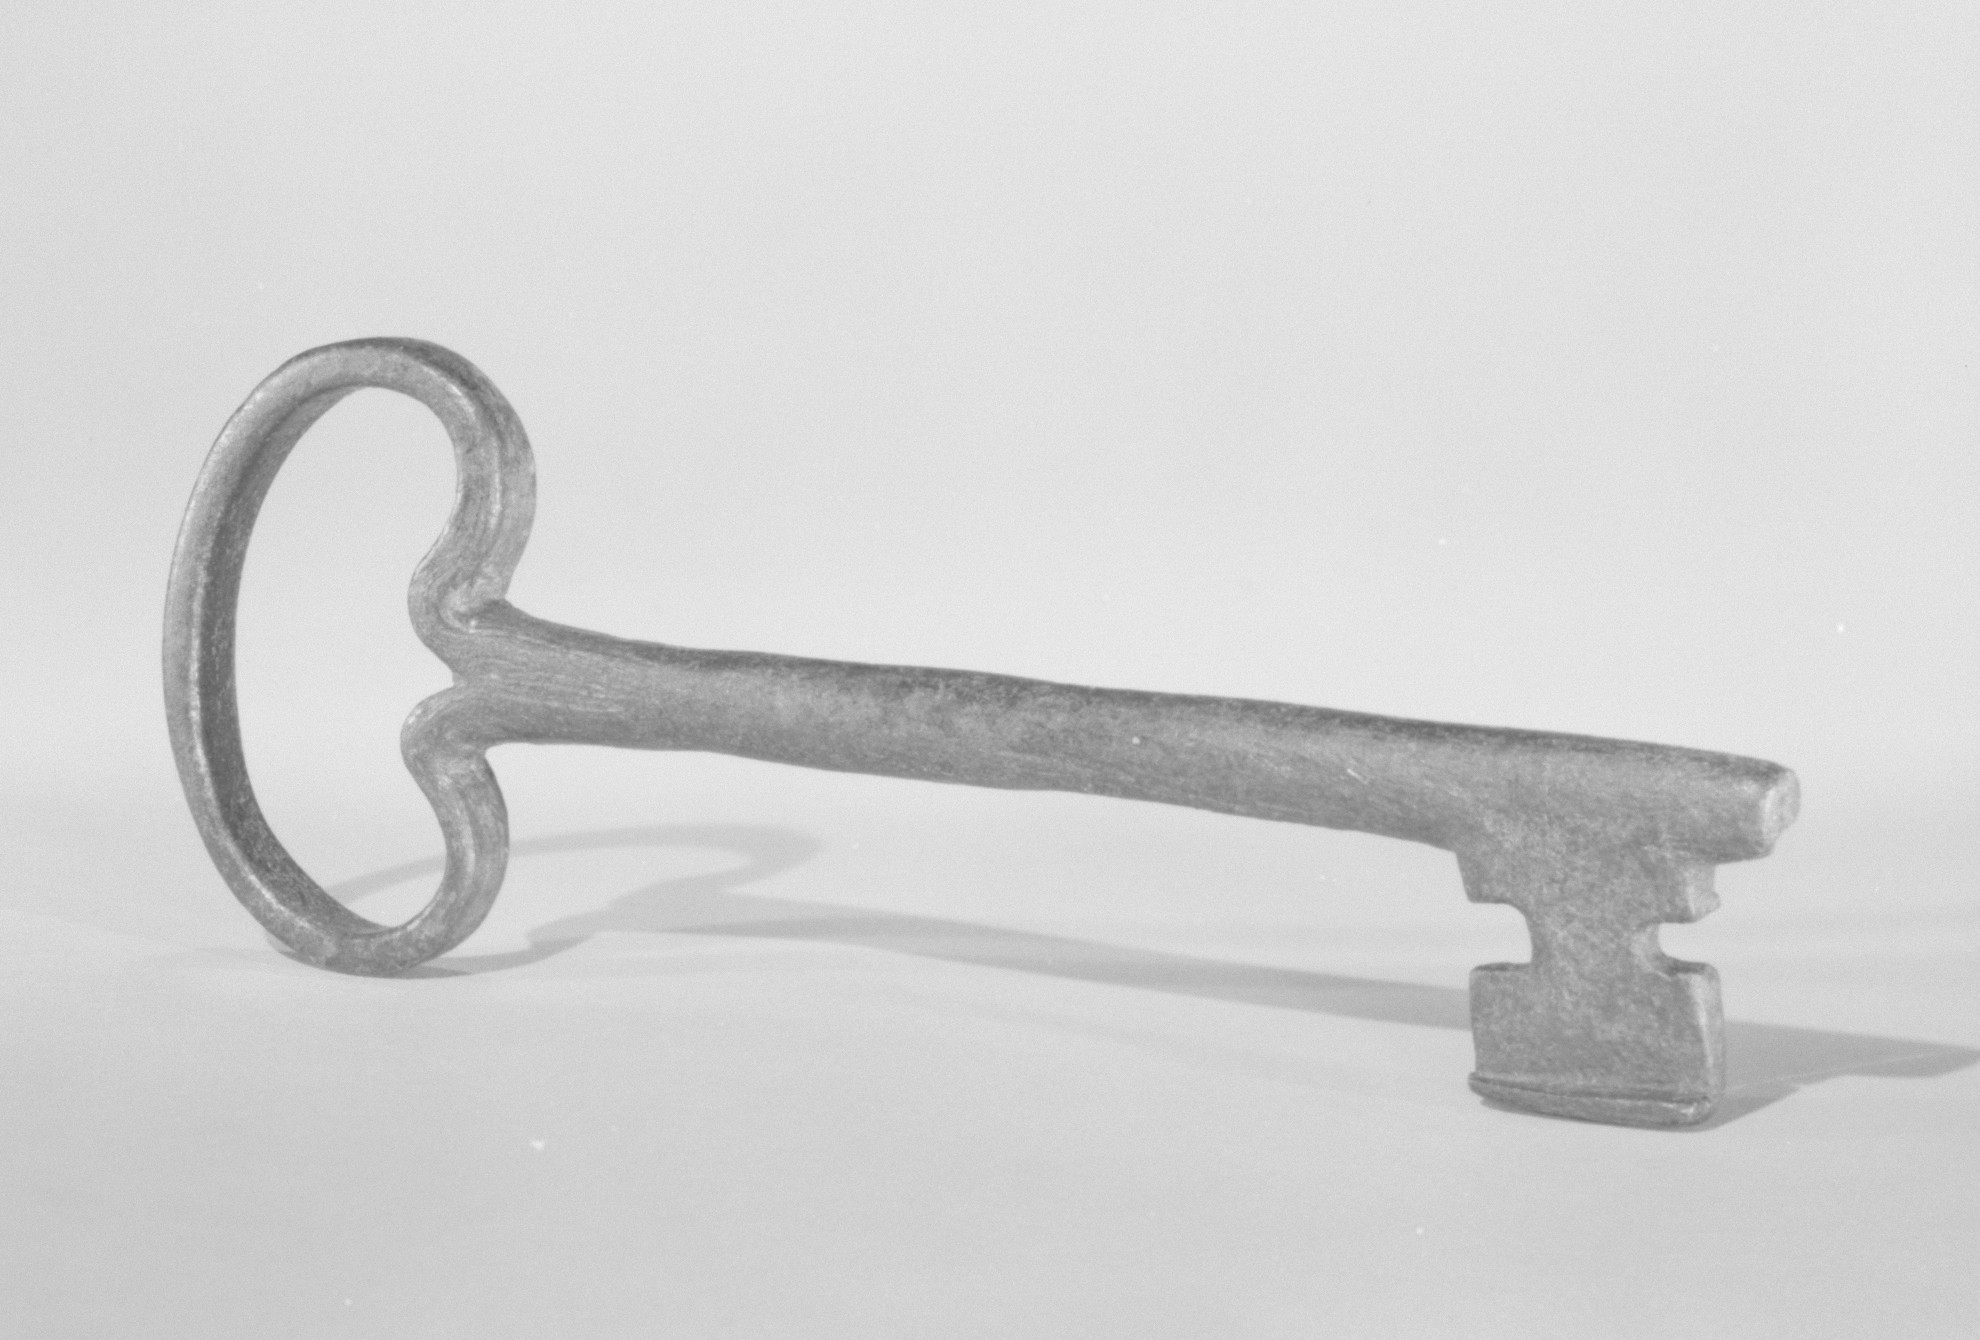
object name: key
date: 1601-1800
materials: iron